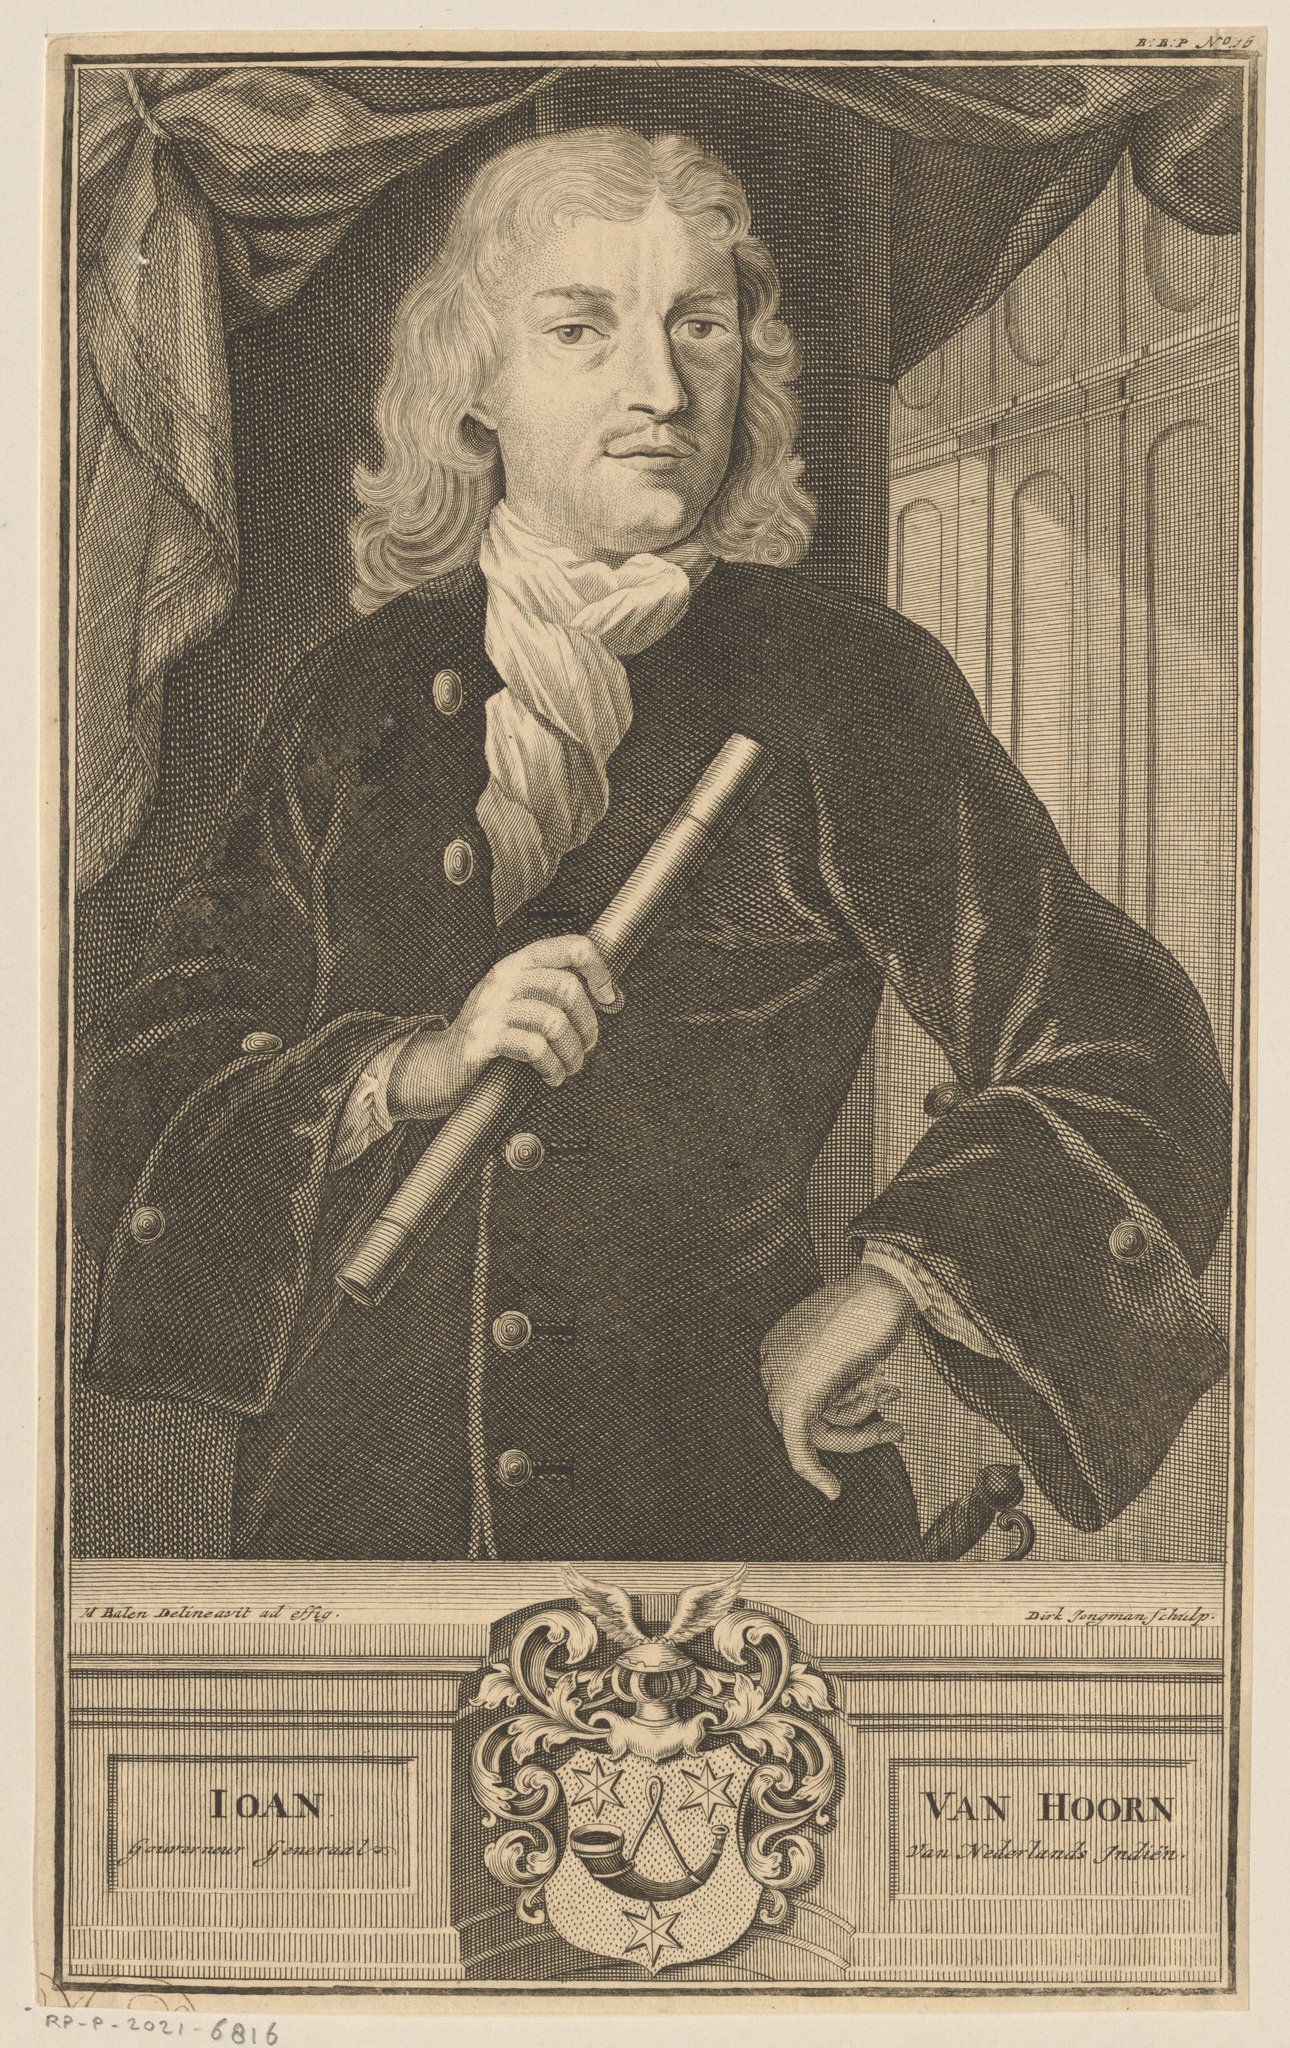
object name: book illustration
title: Portret van Joan van Hoorn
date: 1726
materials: paper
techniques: engraving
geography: dordrecht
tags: amsterdam, colonial governor, historical persons, baton of general, armorial bearing, heraldry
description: Prent uit: Valentijn, François. Oud en nieuw Oost-Indien, vervattende een naaukeurige en uitvoerige verhandelinge van Nederlands mogentheyd in die gewesten (...). Dordrecht en Amsterdam: Johannes van Braam en Gerard onder de Linden, 1726, dl. 4.